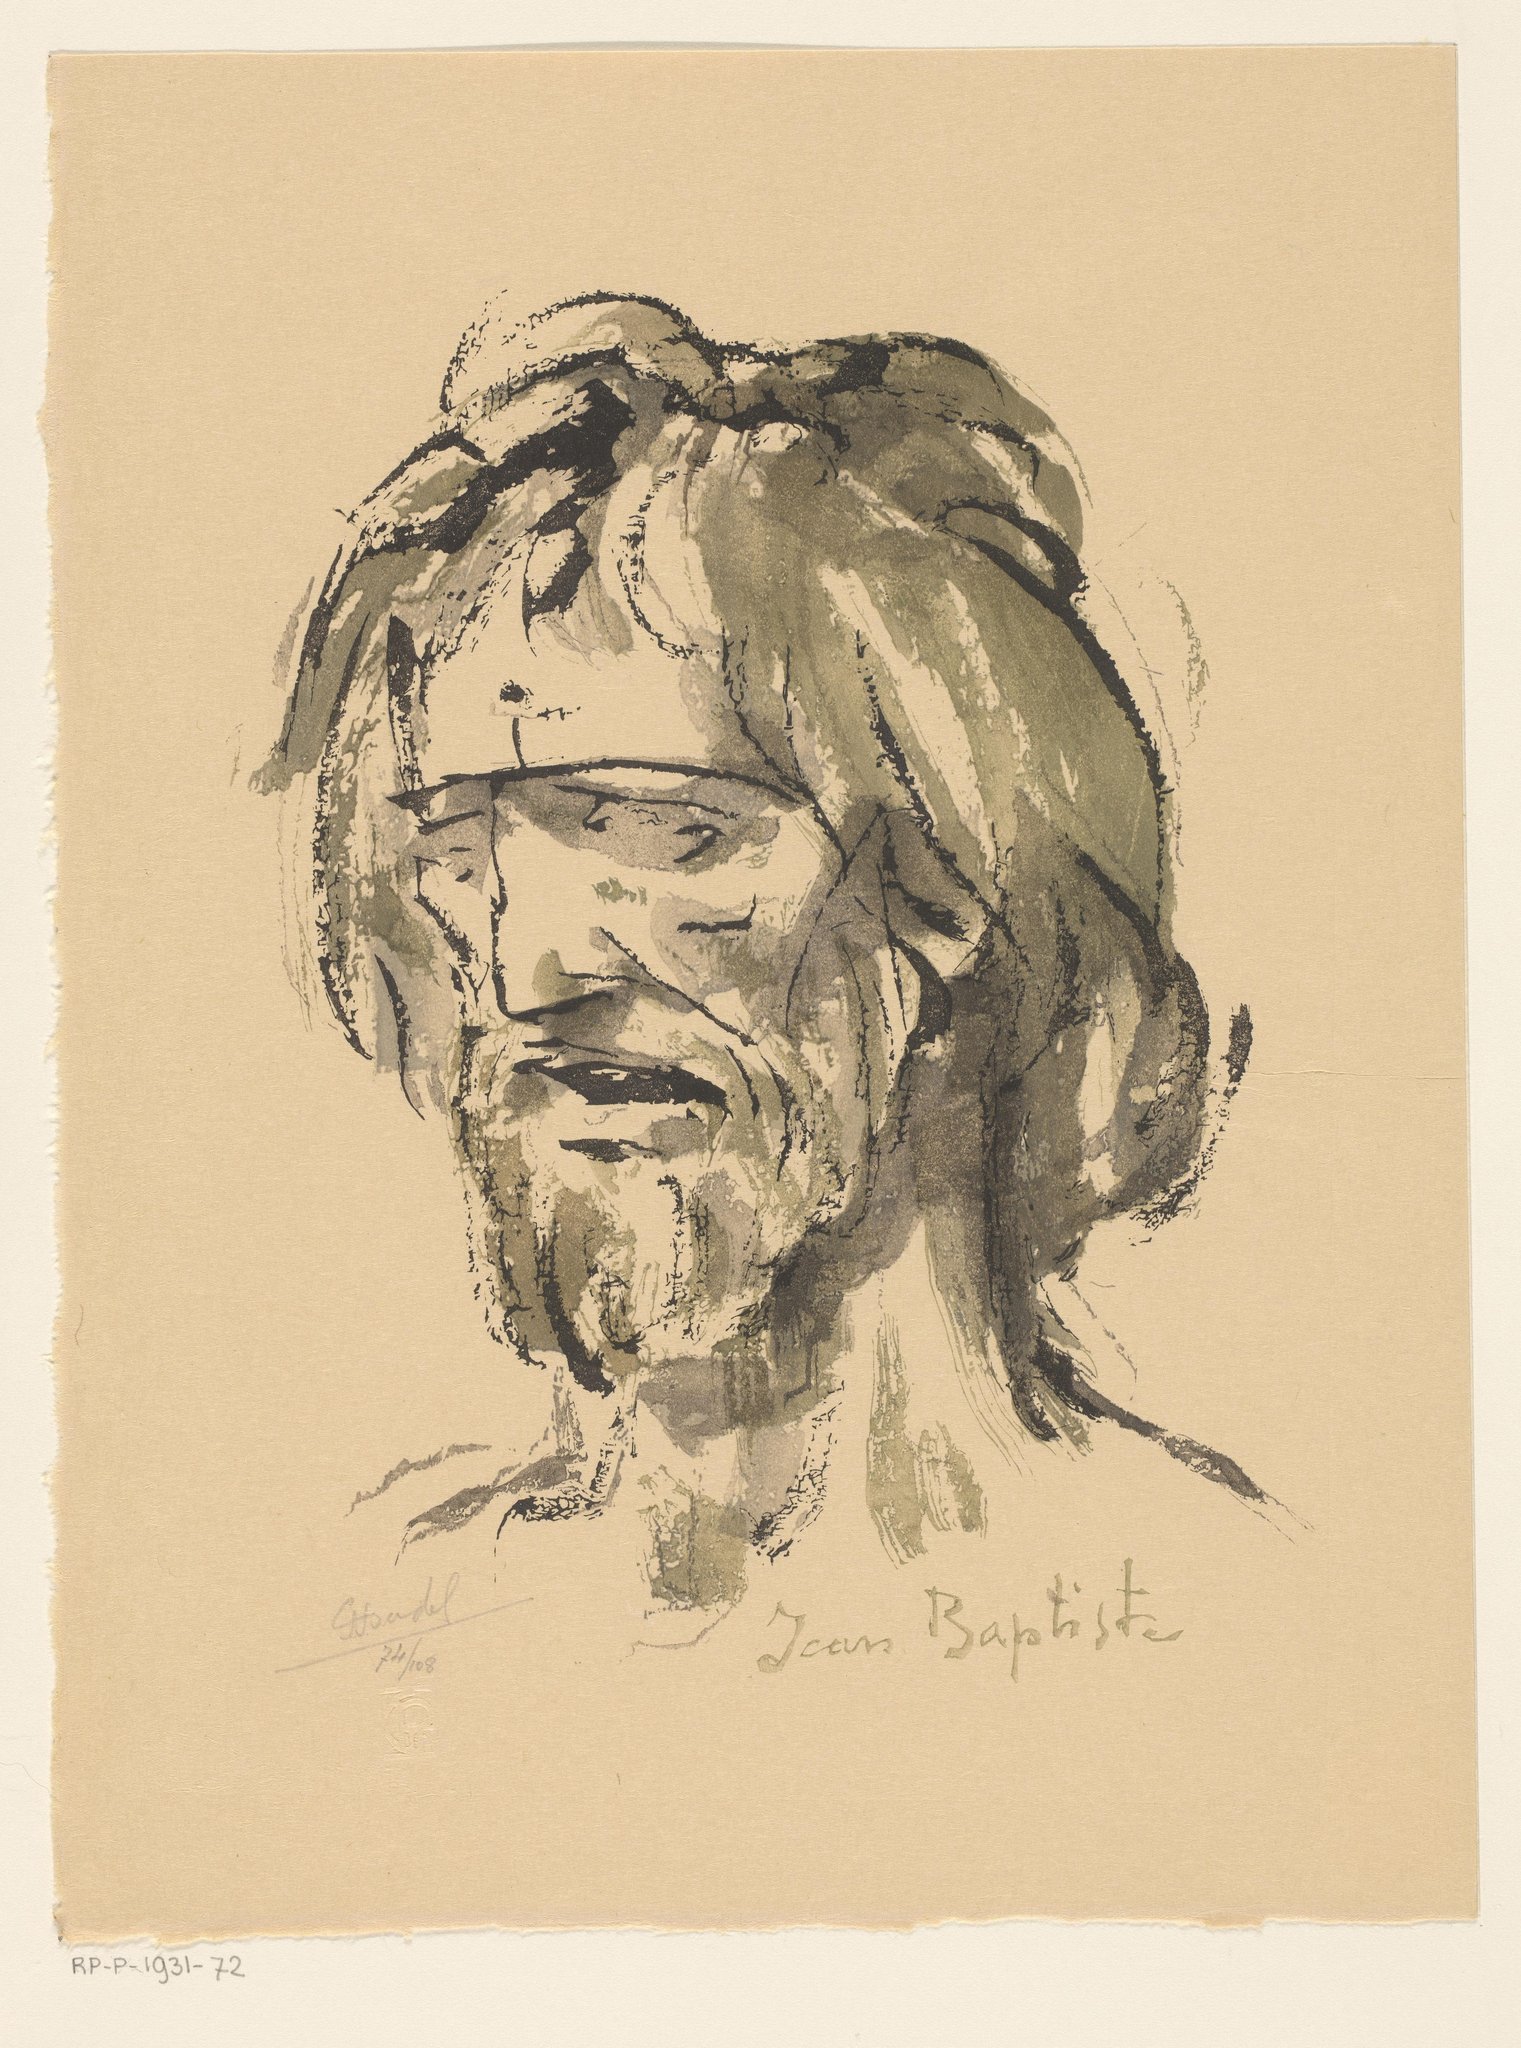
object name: print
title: Jean Baptiste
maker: jules chadel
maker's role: draughtsman, print maker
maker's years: 1870-1941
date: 1931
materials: paper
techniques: woodcut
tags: john the baptist; possible attributes: book, reed cross, baptismal cup, honeycomb, lamb, staff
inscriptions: collector's mark: Lugt 2228, check stamp: Lugt 1195a